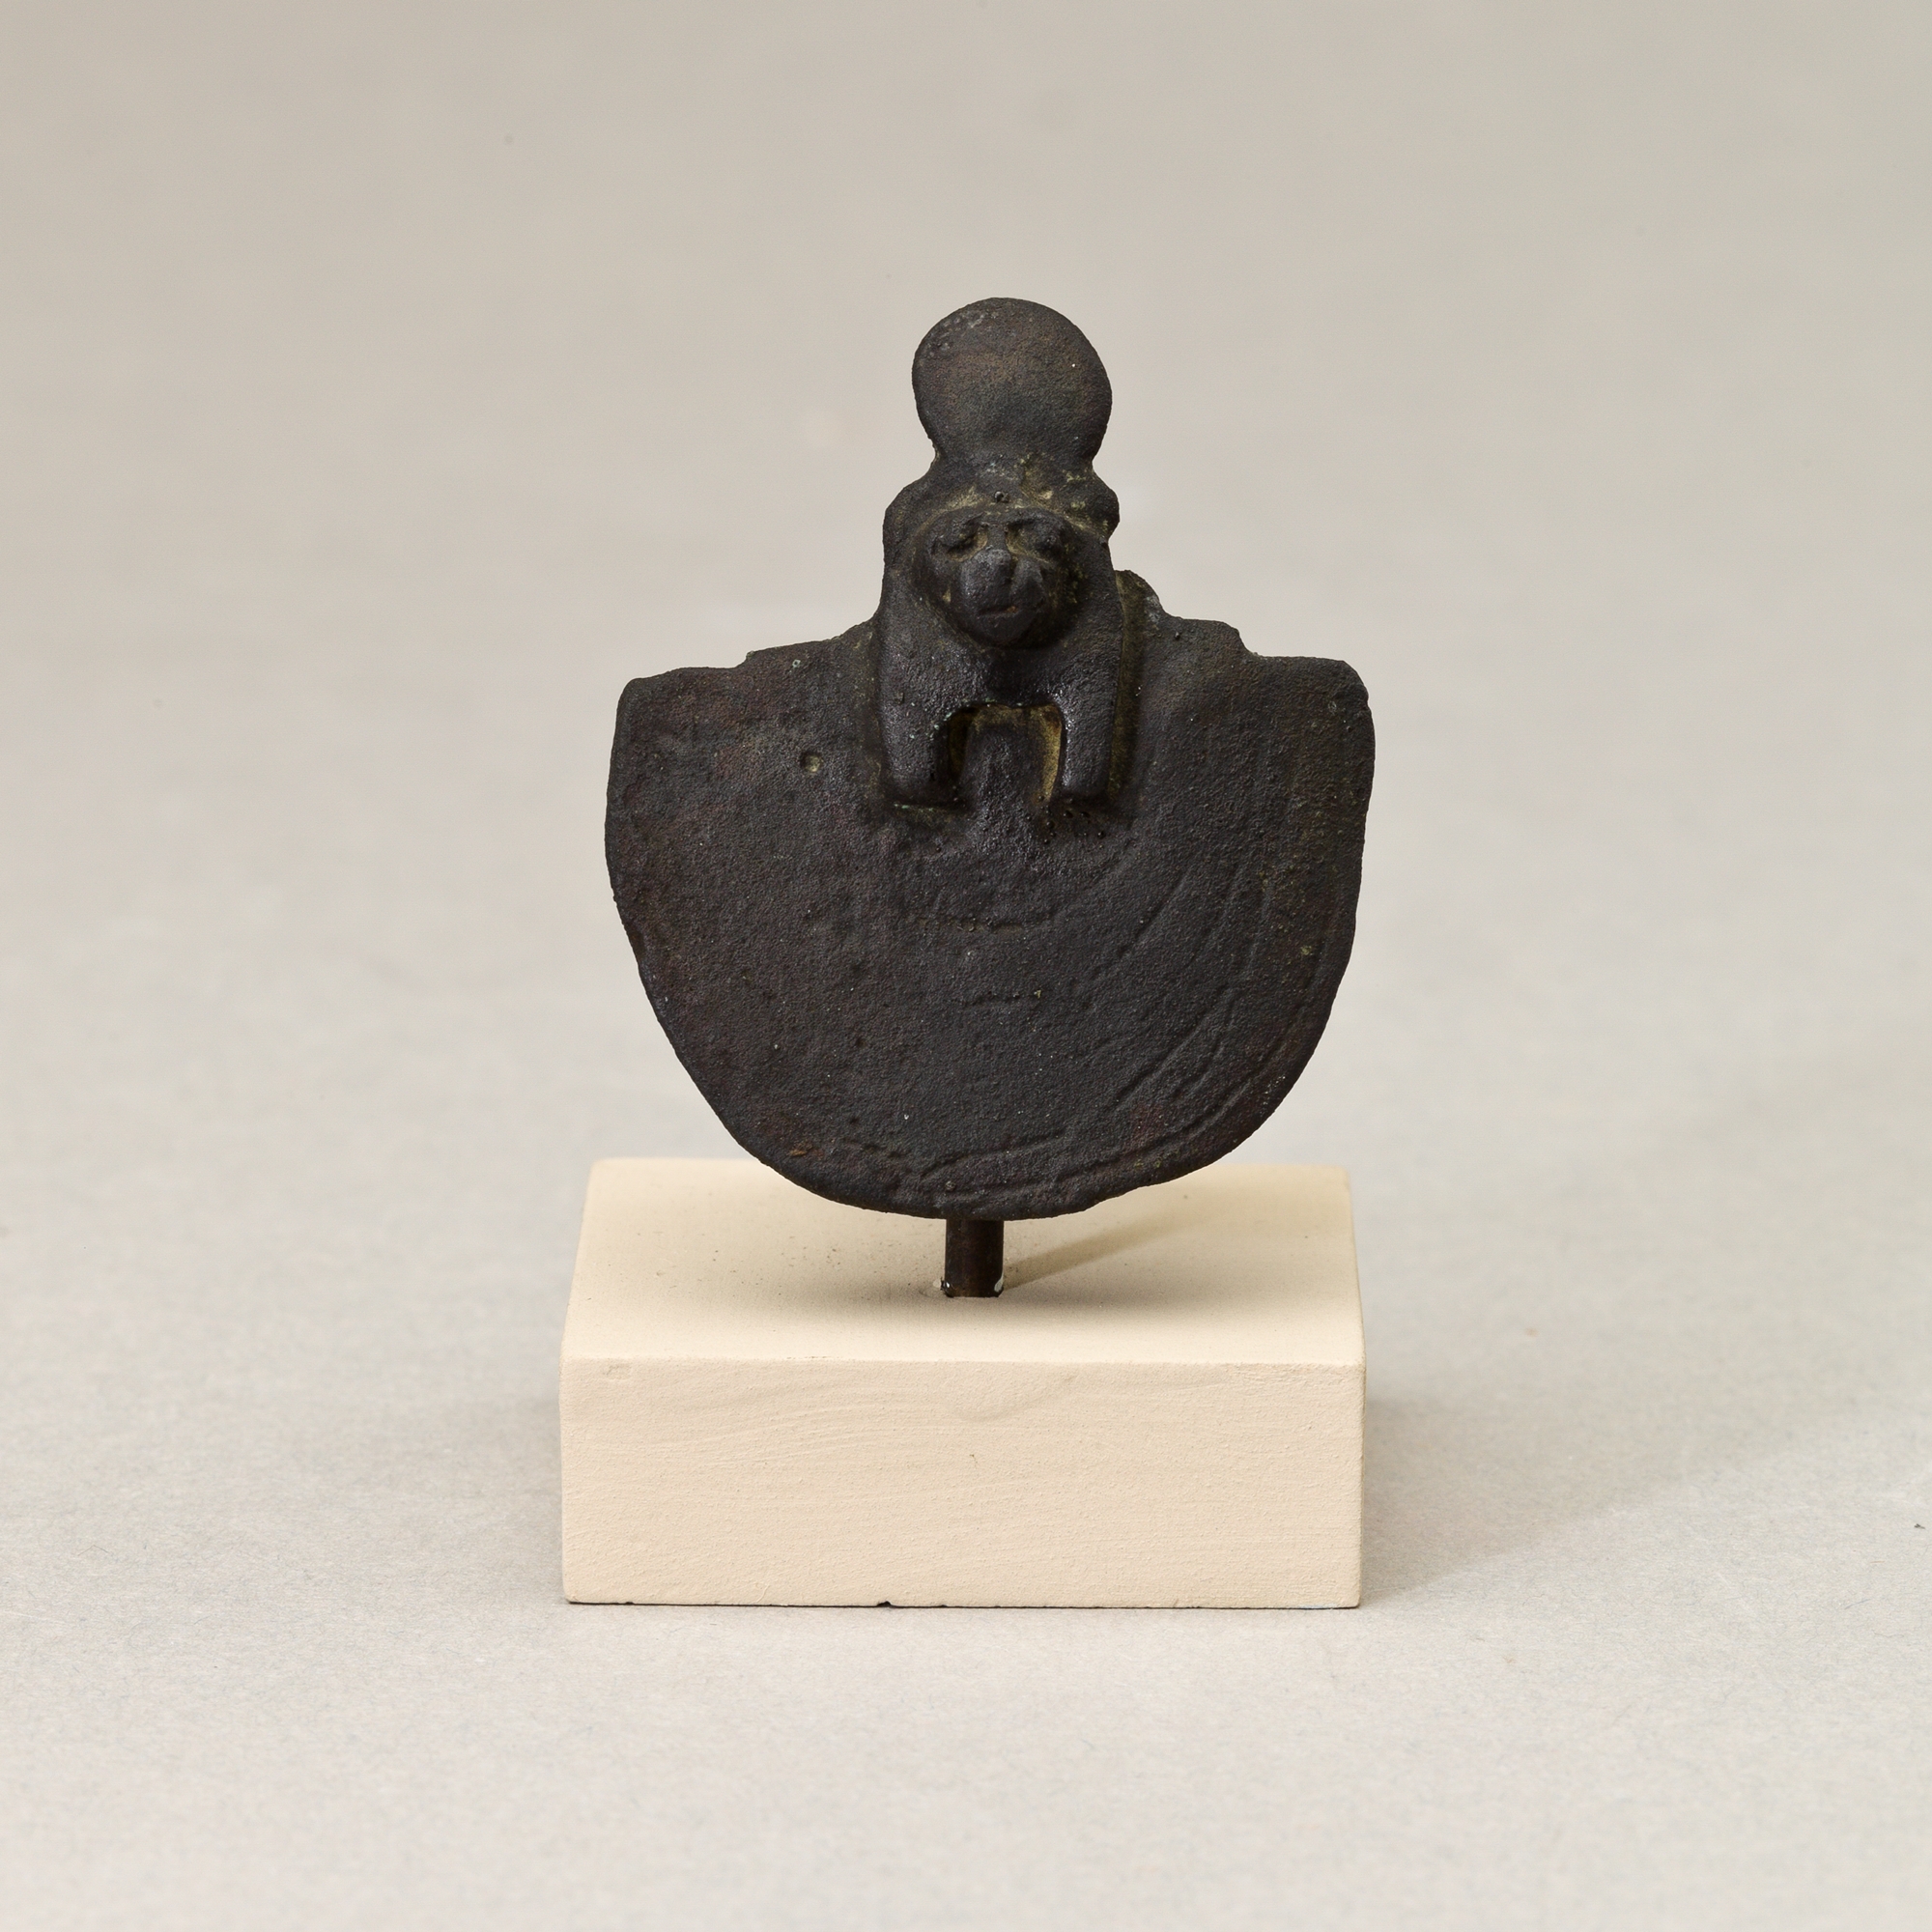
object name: amulet, aegis, bastet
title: Aegis of Bastet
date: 664-630 BCE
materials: metal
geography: egypt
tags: goddess